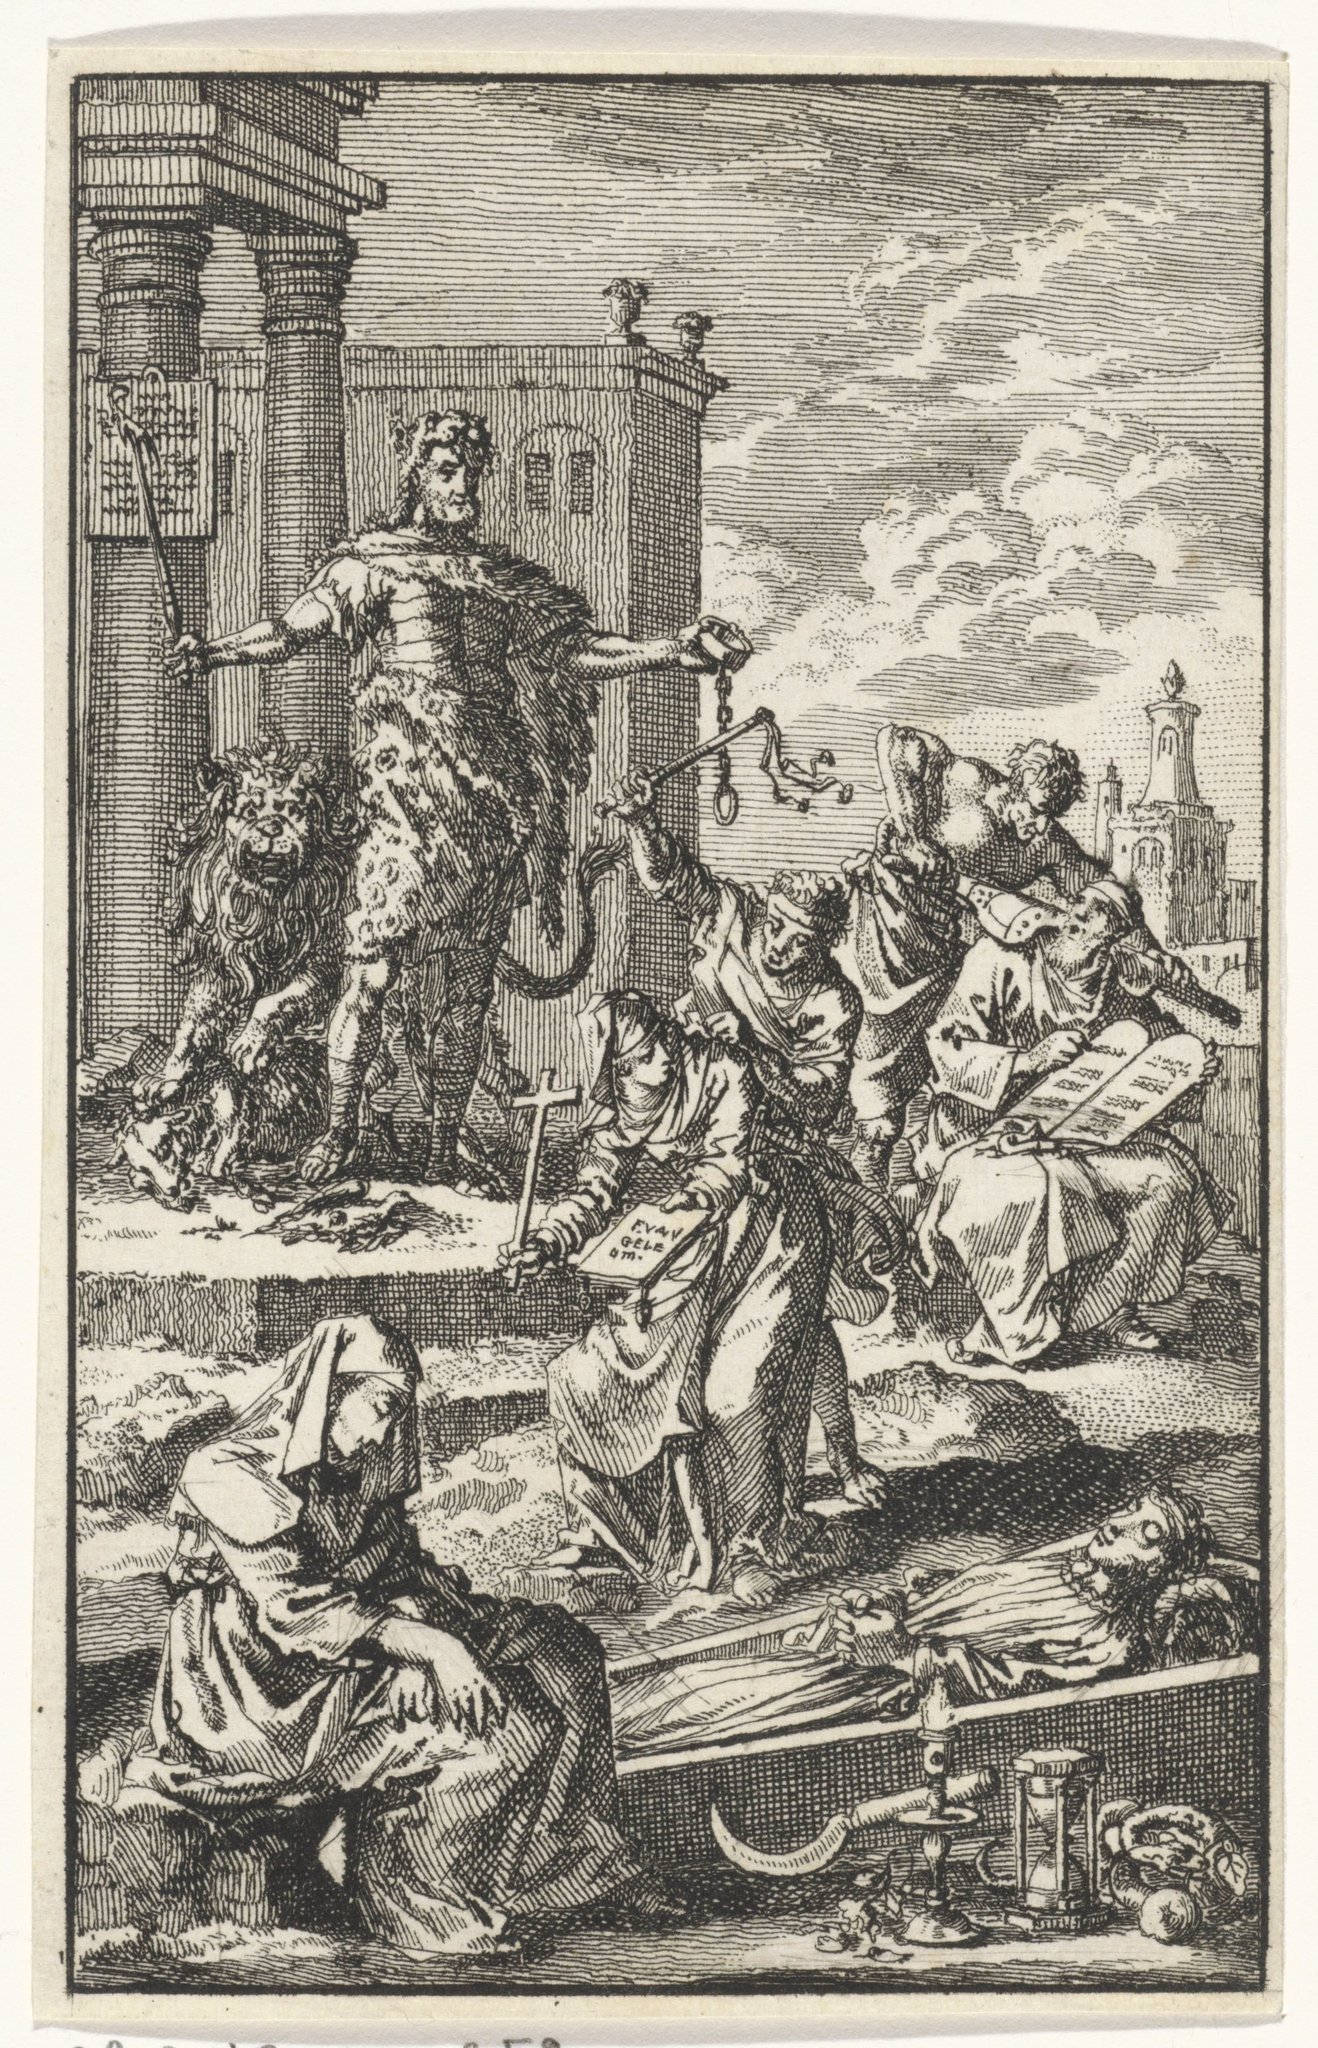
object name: print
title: Tiran kijkt toe hoe de personificaties van de Wet en het Geloof worden onderdrukt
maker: jan luyken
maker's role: draughtsman, print maker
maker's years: 1649-1712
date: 1706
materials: paper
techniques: etching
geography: amsterdam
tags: eunomia, personification of law and order, faith, 'fides'; 'fede', 'fede catholica', 'fede christiana', 'fede christiana catholica' (ripa) ~ one of the three theological virtues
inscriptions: collector's mark: Lugt 2228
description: Proefdruk van illustratie voor: Bouman, Herkules. Waereld vol stryd. Amsterdam: Jacob van Royen, 1706.